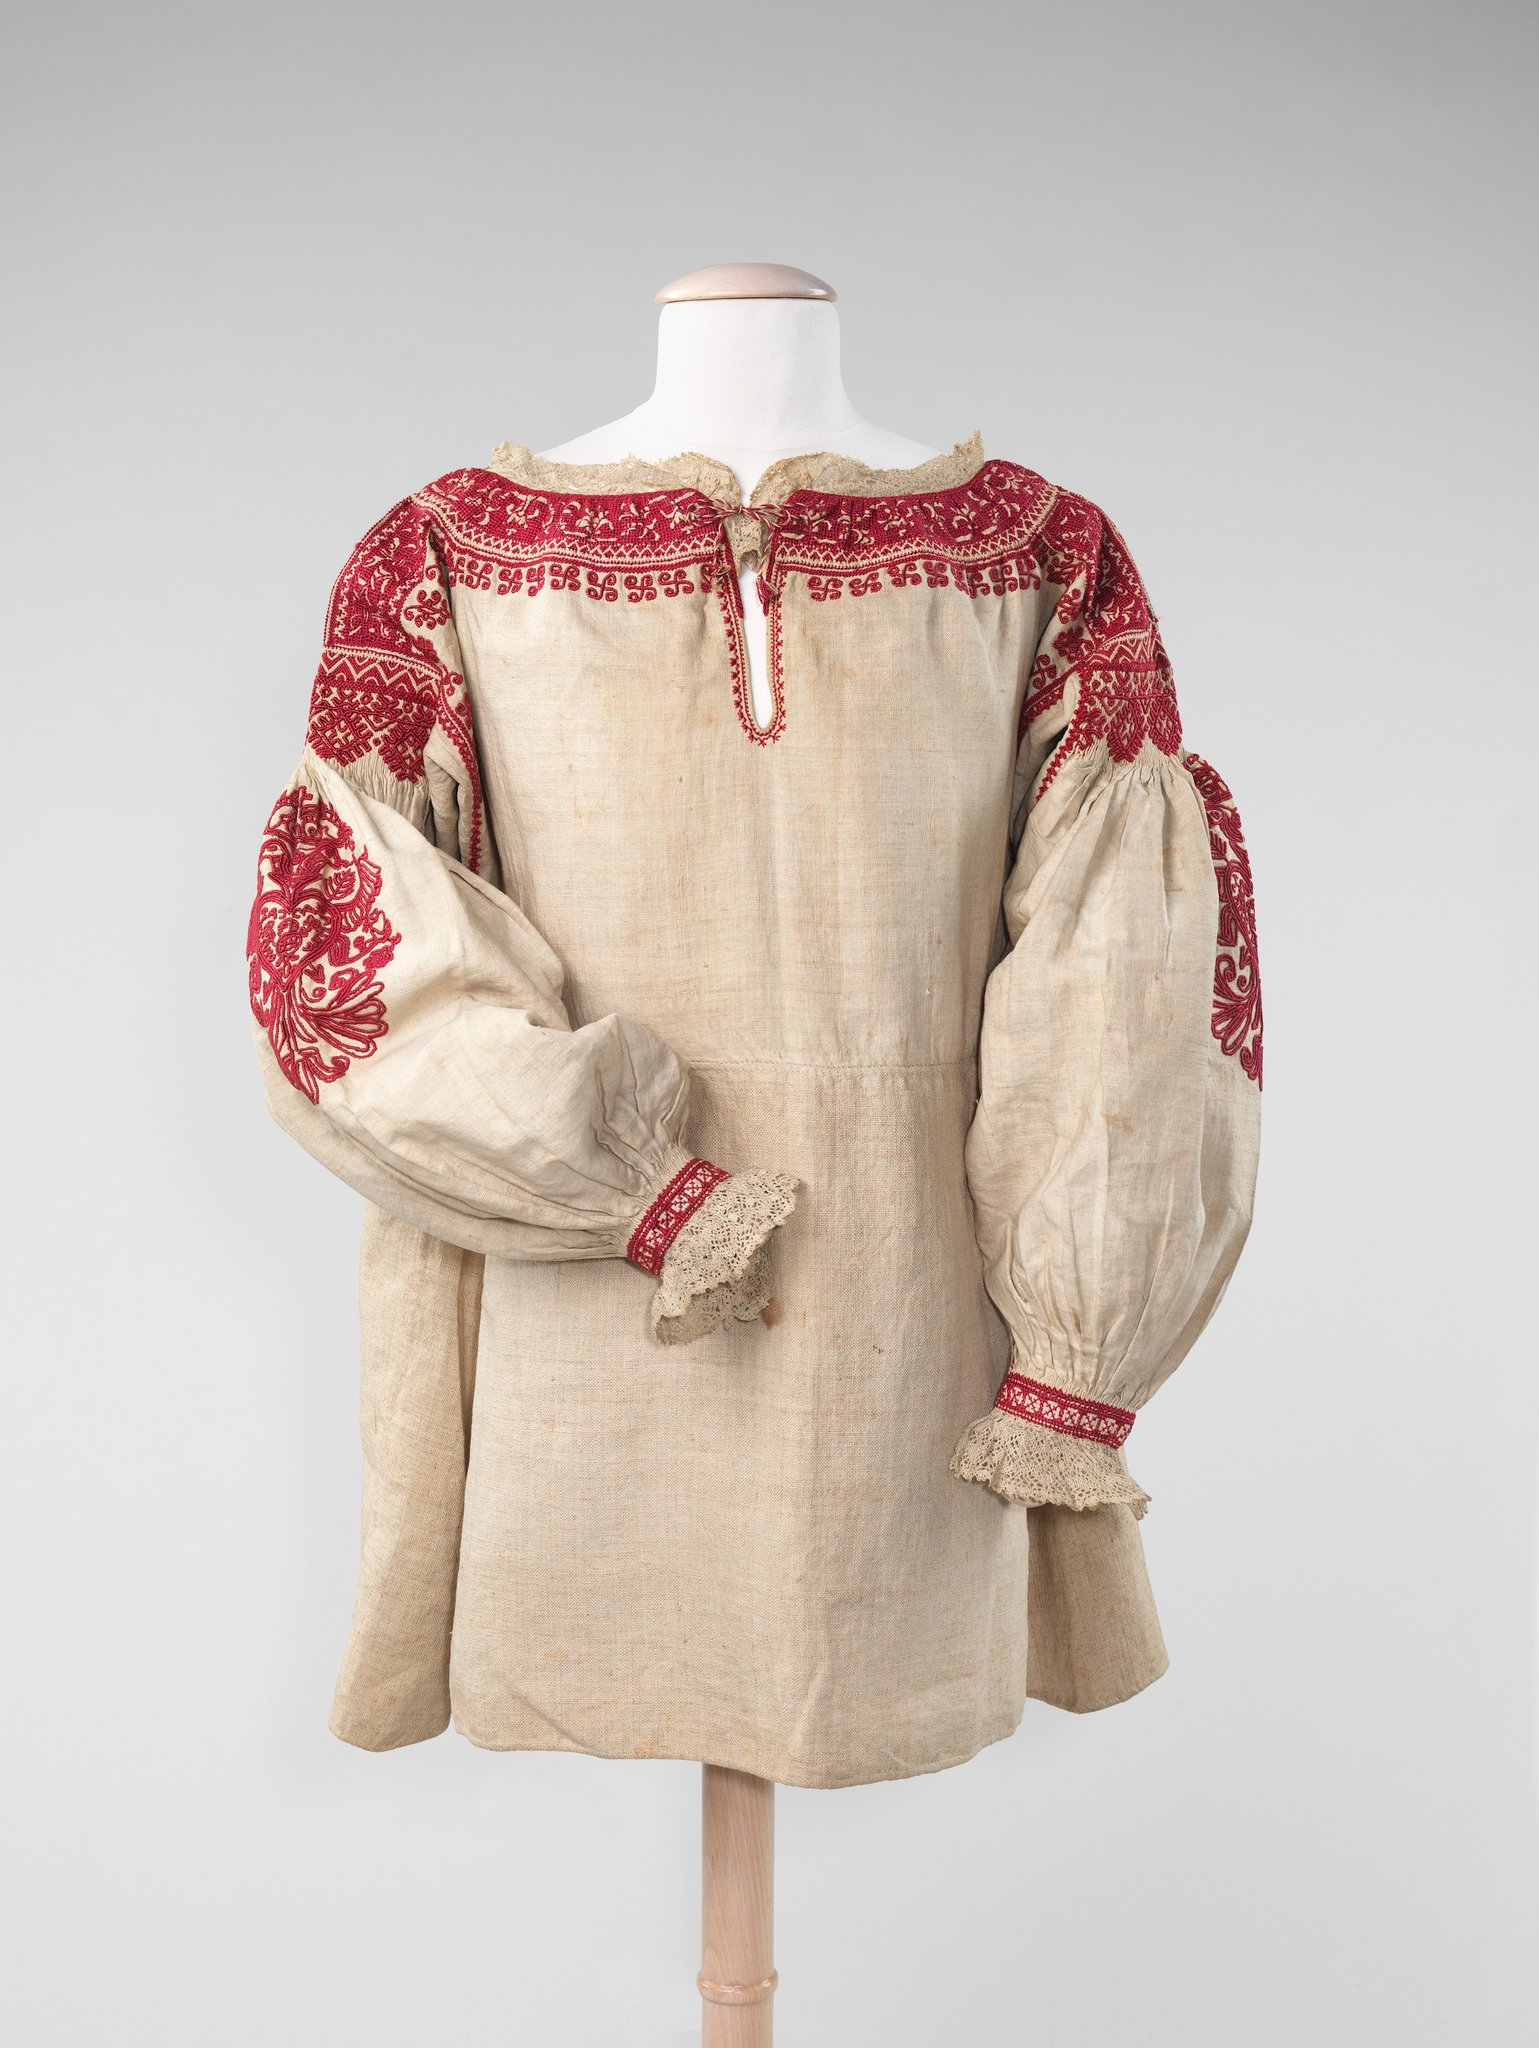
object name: blouse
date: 1867-1900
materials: linen, silk